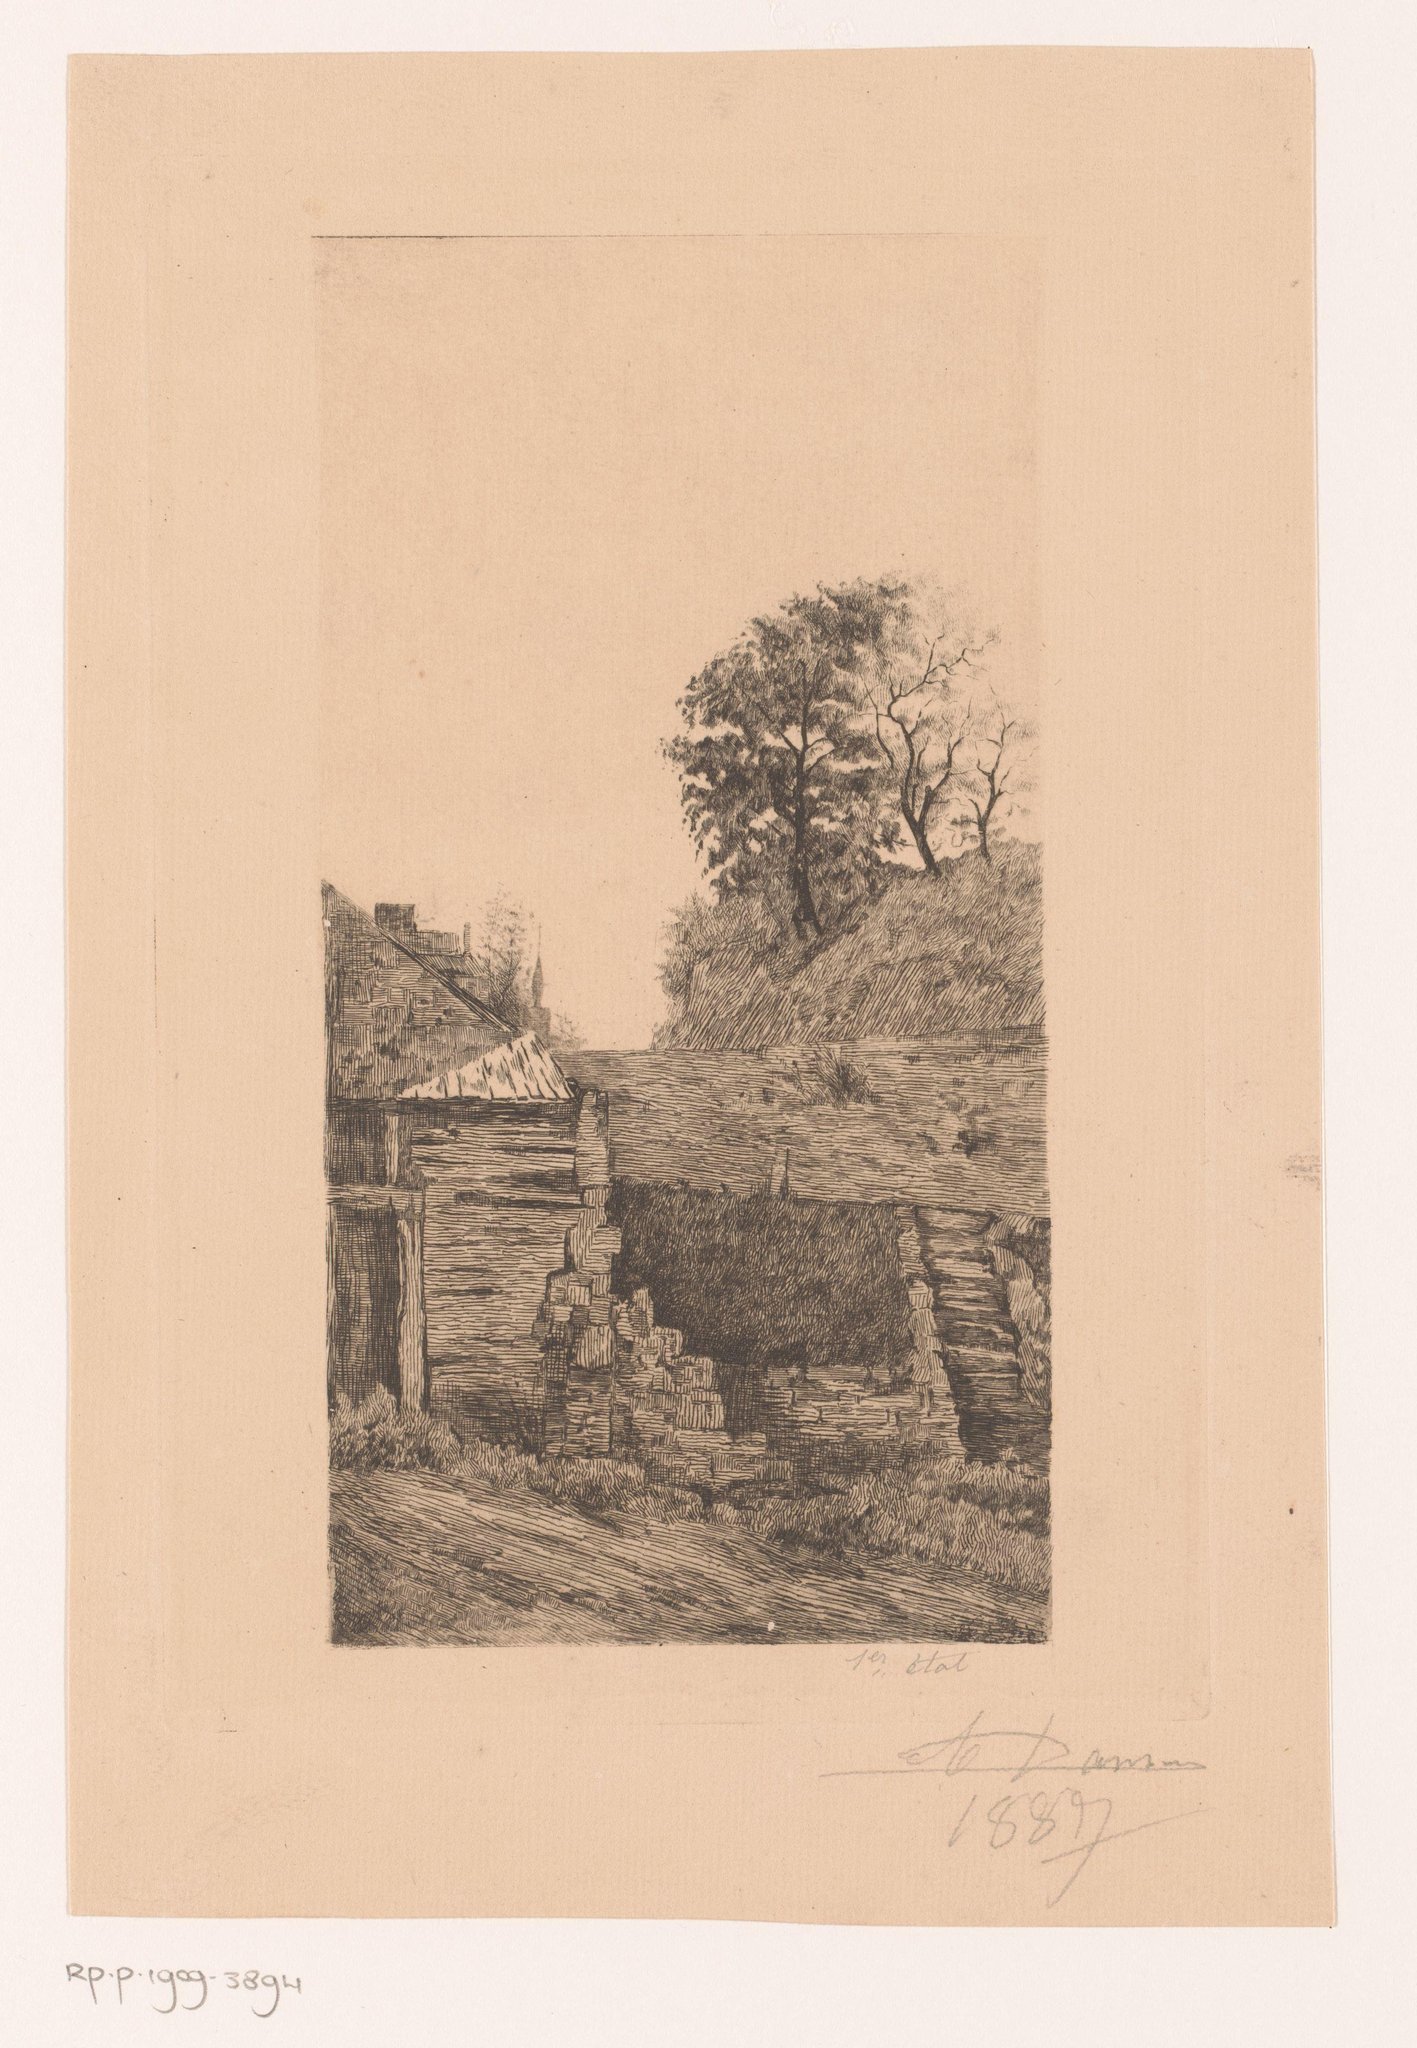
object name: print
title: Gezicht bij Bouillon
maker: auguste danse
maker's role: print maker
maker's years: 1829-1929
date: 1887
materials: paper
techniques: etching, intaglio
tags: village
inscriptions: annotation: ‘1er état’, collector's mark: Lugt 2228